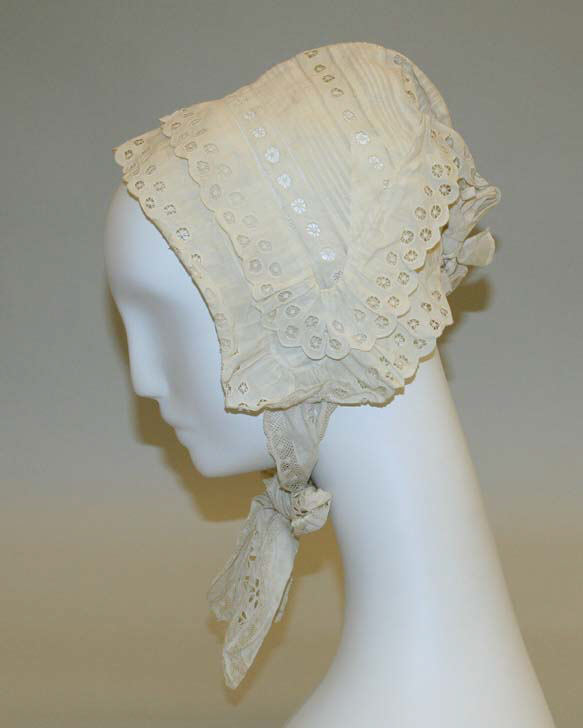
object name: cap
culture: american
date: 1801-1900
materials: cotton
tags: flowers